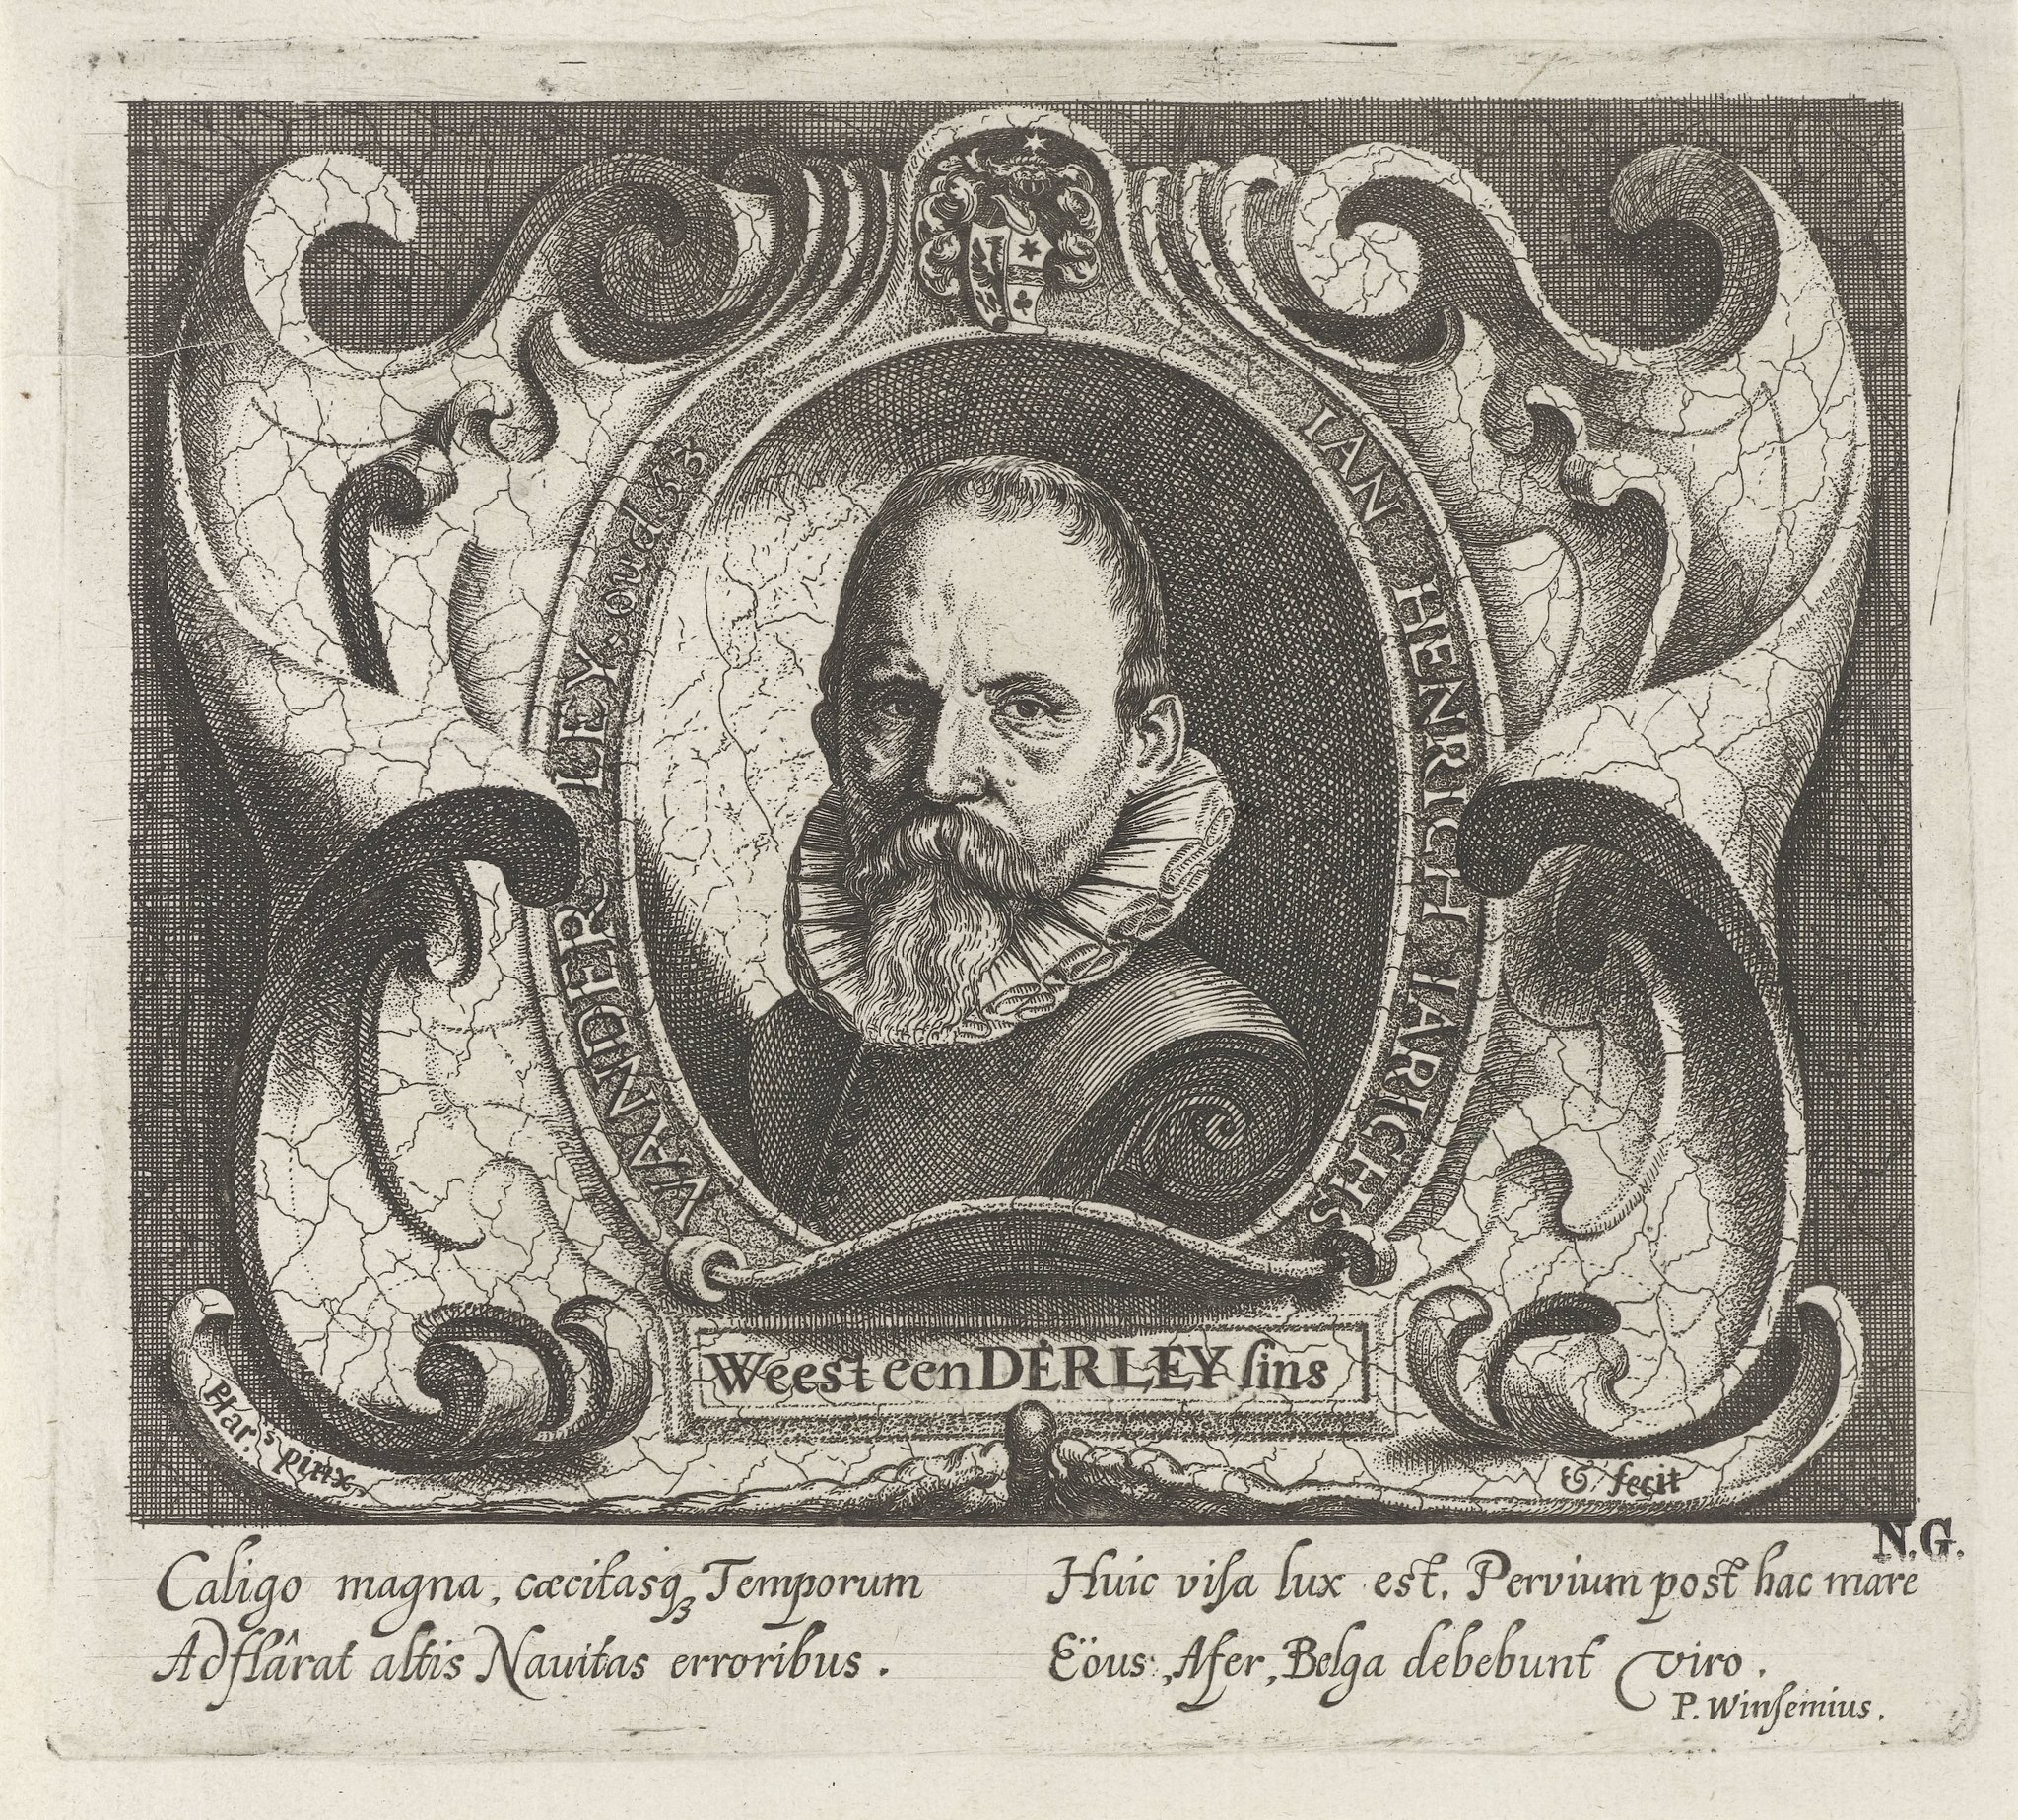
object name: print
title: Portret van Jan Henrich Jarichs van der Ley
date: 1619-1623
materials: paper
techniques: etching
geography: friesland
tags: jan henrich jarichs van der ley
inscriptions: collector's mark: Lugt 1968, collector's mark: Lugt 2228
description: Busteportret van de Friese wiskundige Jan Henrich Jarichs van der Ley, afgebeeld in cartouche met randschrift op ovale omlijsting en een onderschrift. Het randschrift vermeldt naam en leeftijd. Onder de voorstelling een opschrift in Latijn.